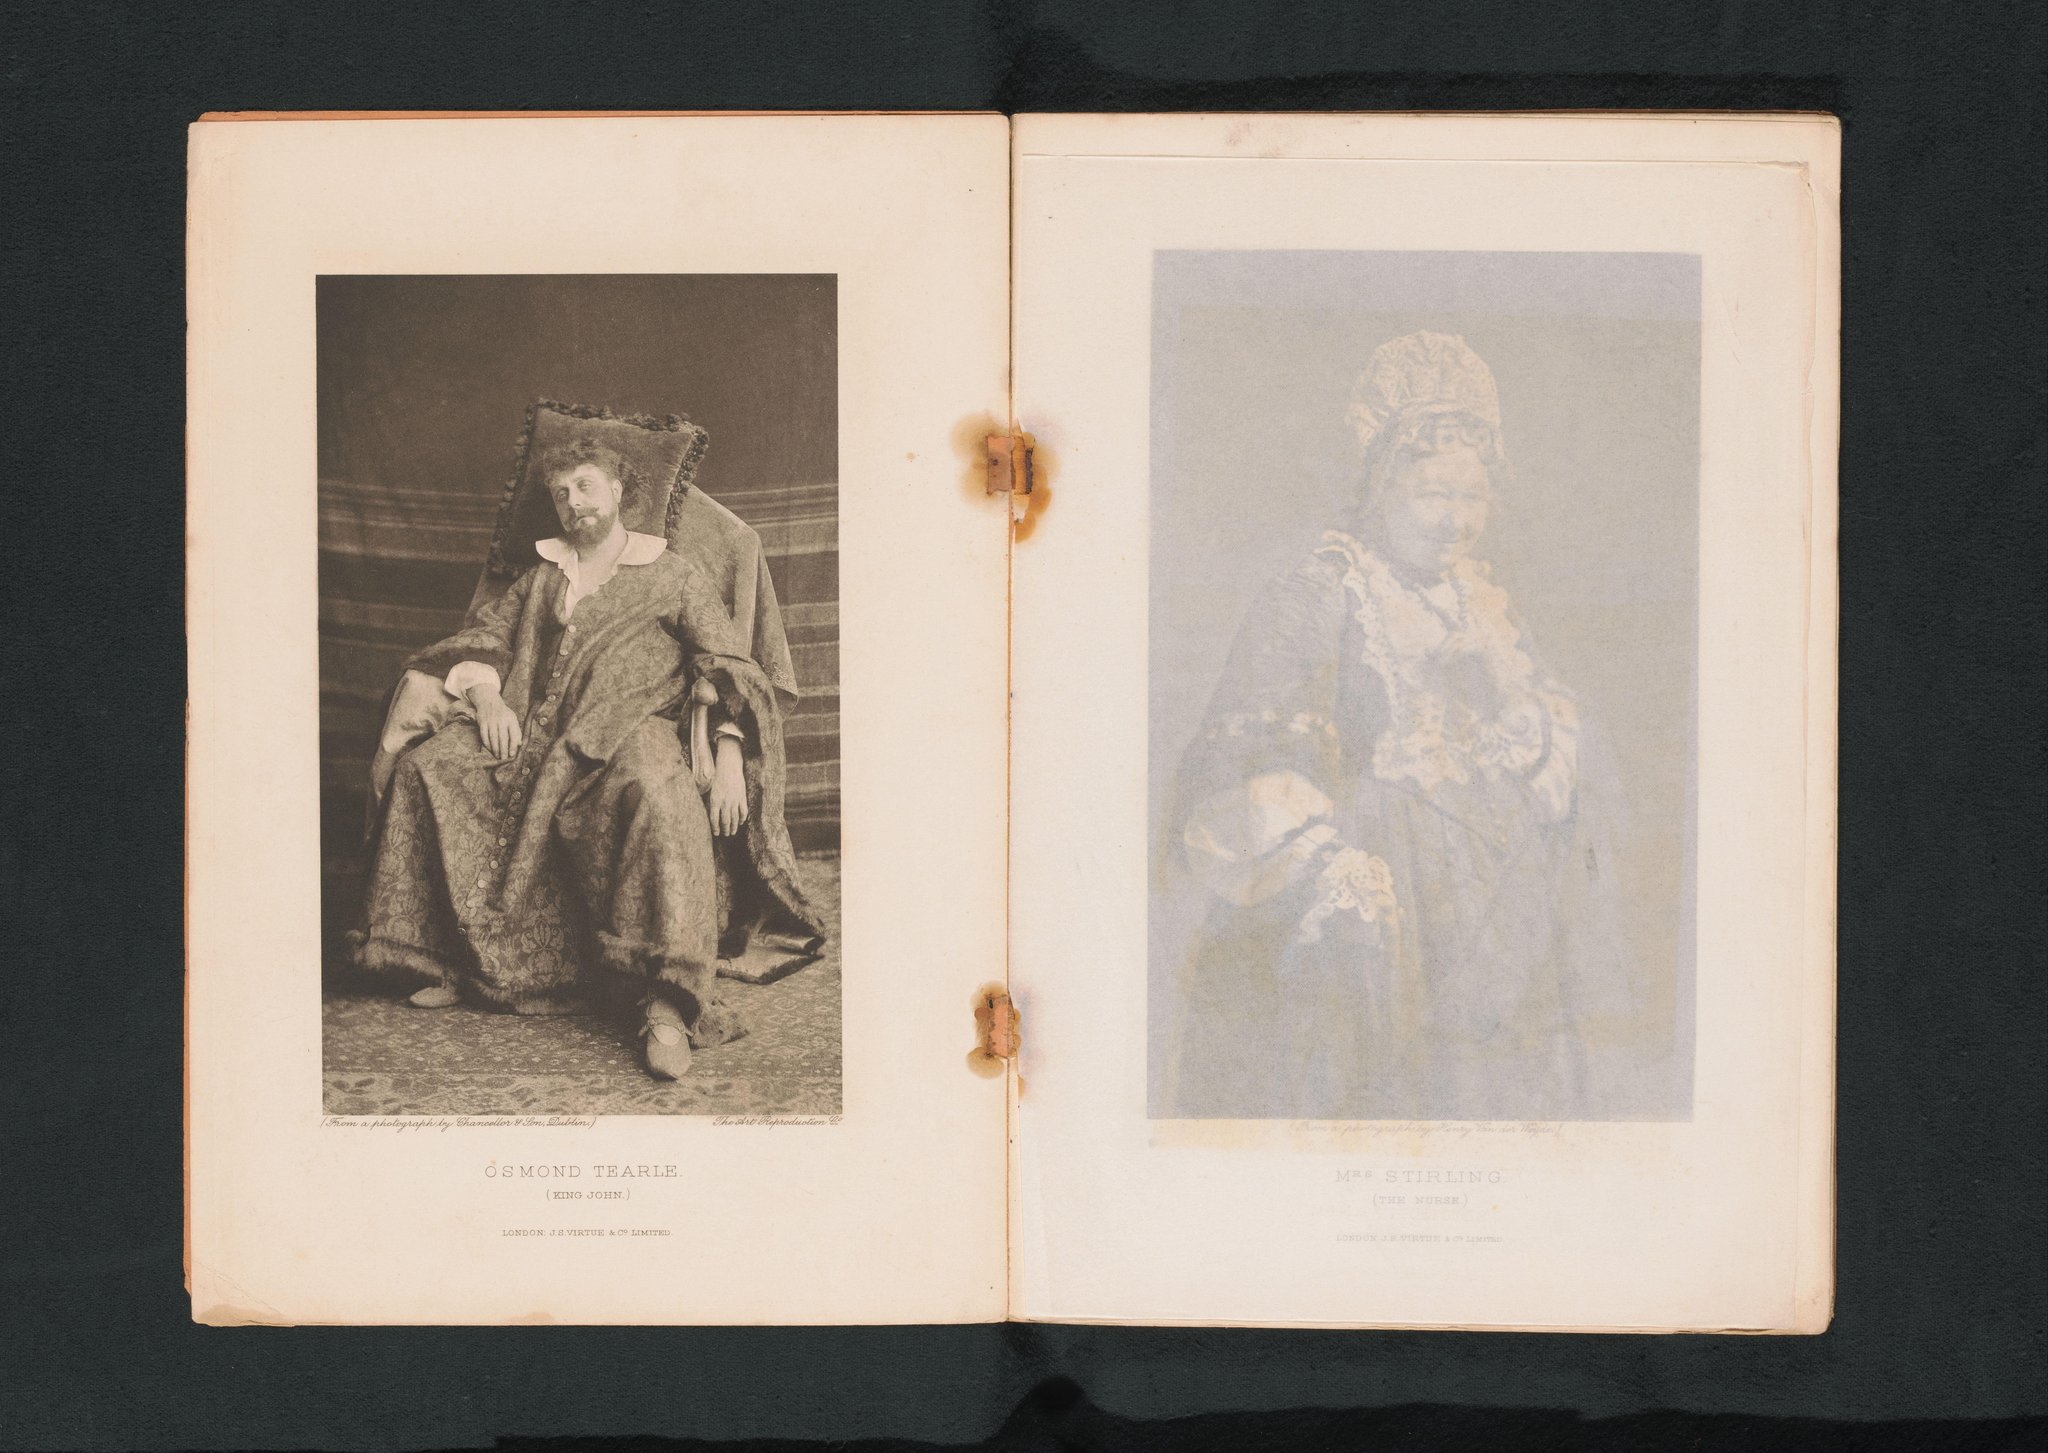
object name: photomechanical print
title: Portret van Osmond Tearle in de rol van King John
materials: paper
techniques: photoaquatint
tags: historical persons, portrait of actor, actress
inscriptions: inscription: ‘(KING JOHN.)’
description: Prent op tweede ongenummerde pagina na voorblad.